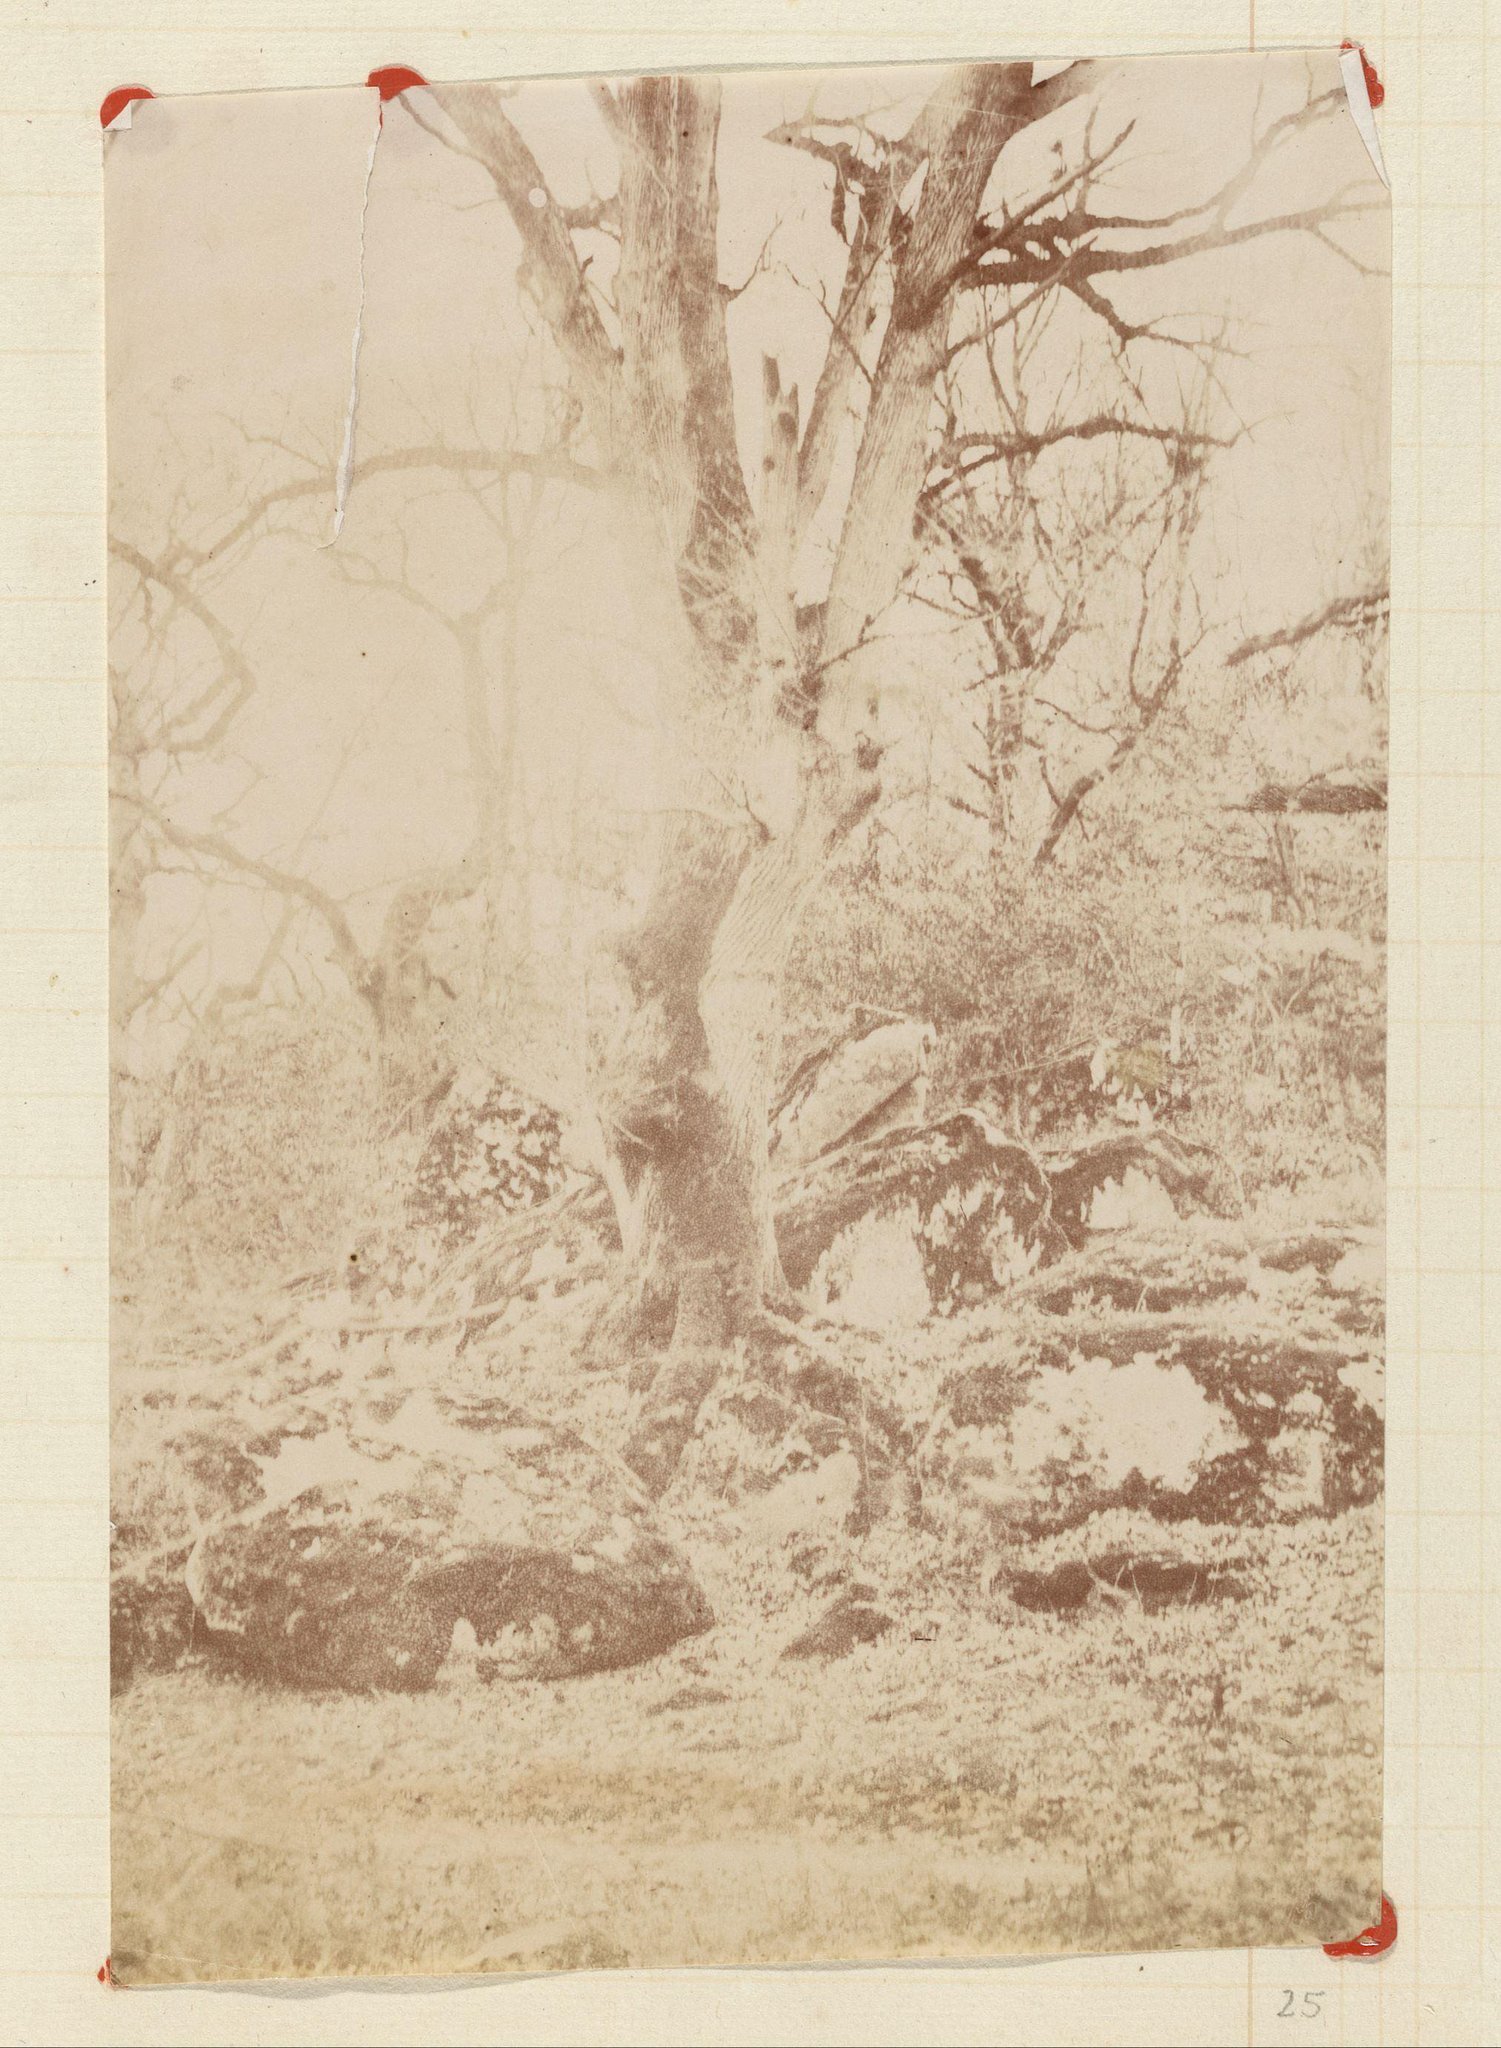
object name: photograph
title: Kale boom in een bos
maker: Anonymous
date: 1880-1900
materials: lacquer, paper, photographic support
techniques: albumen print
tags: trees